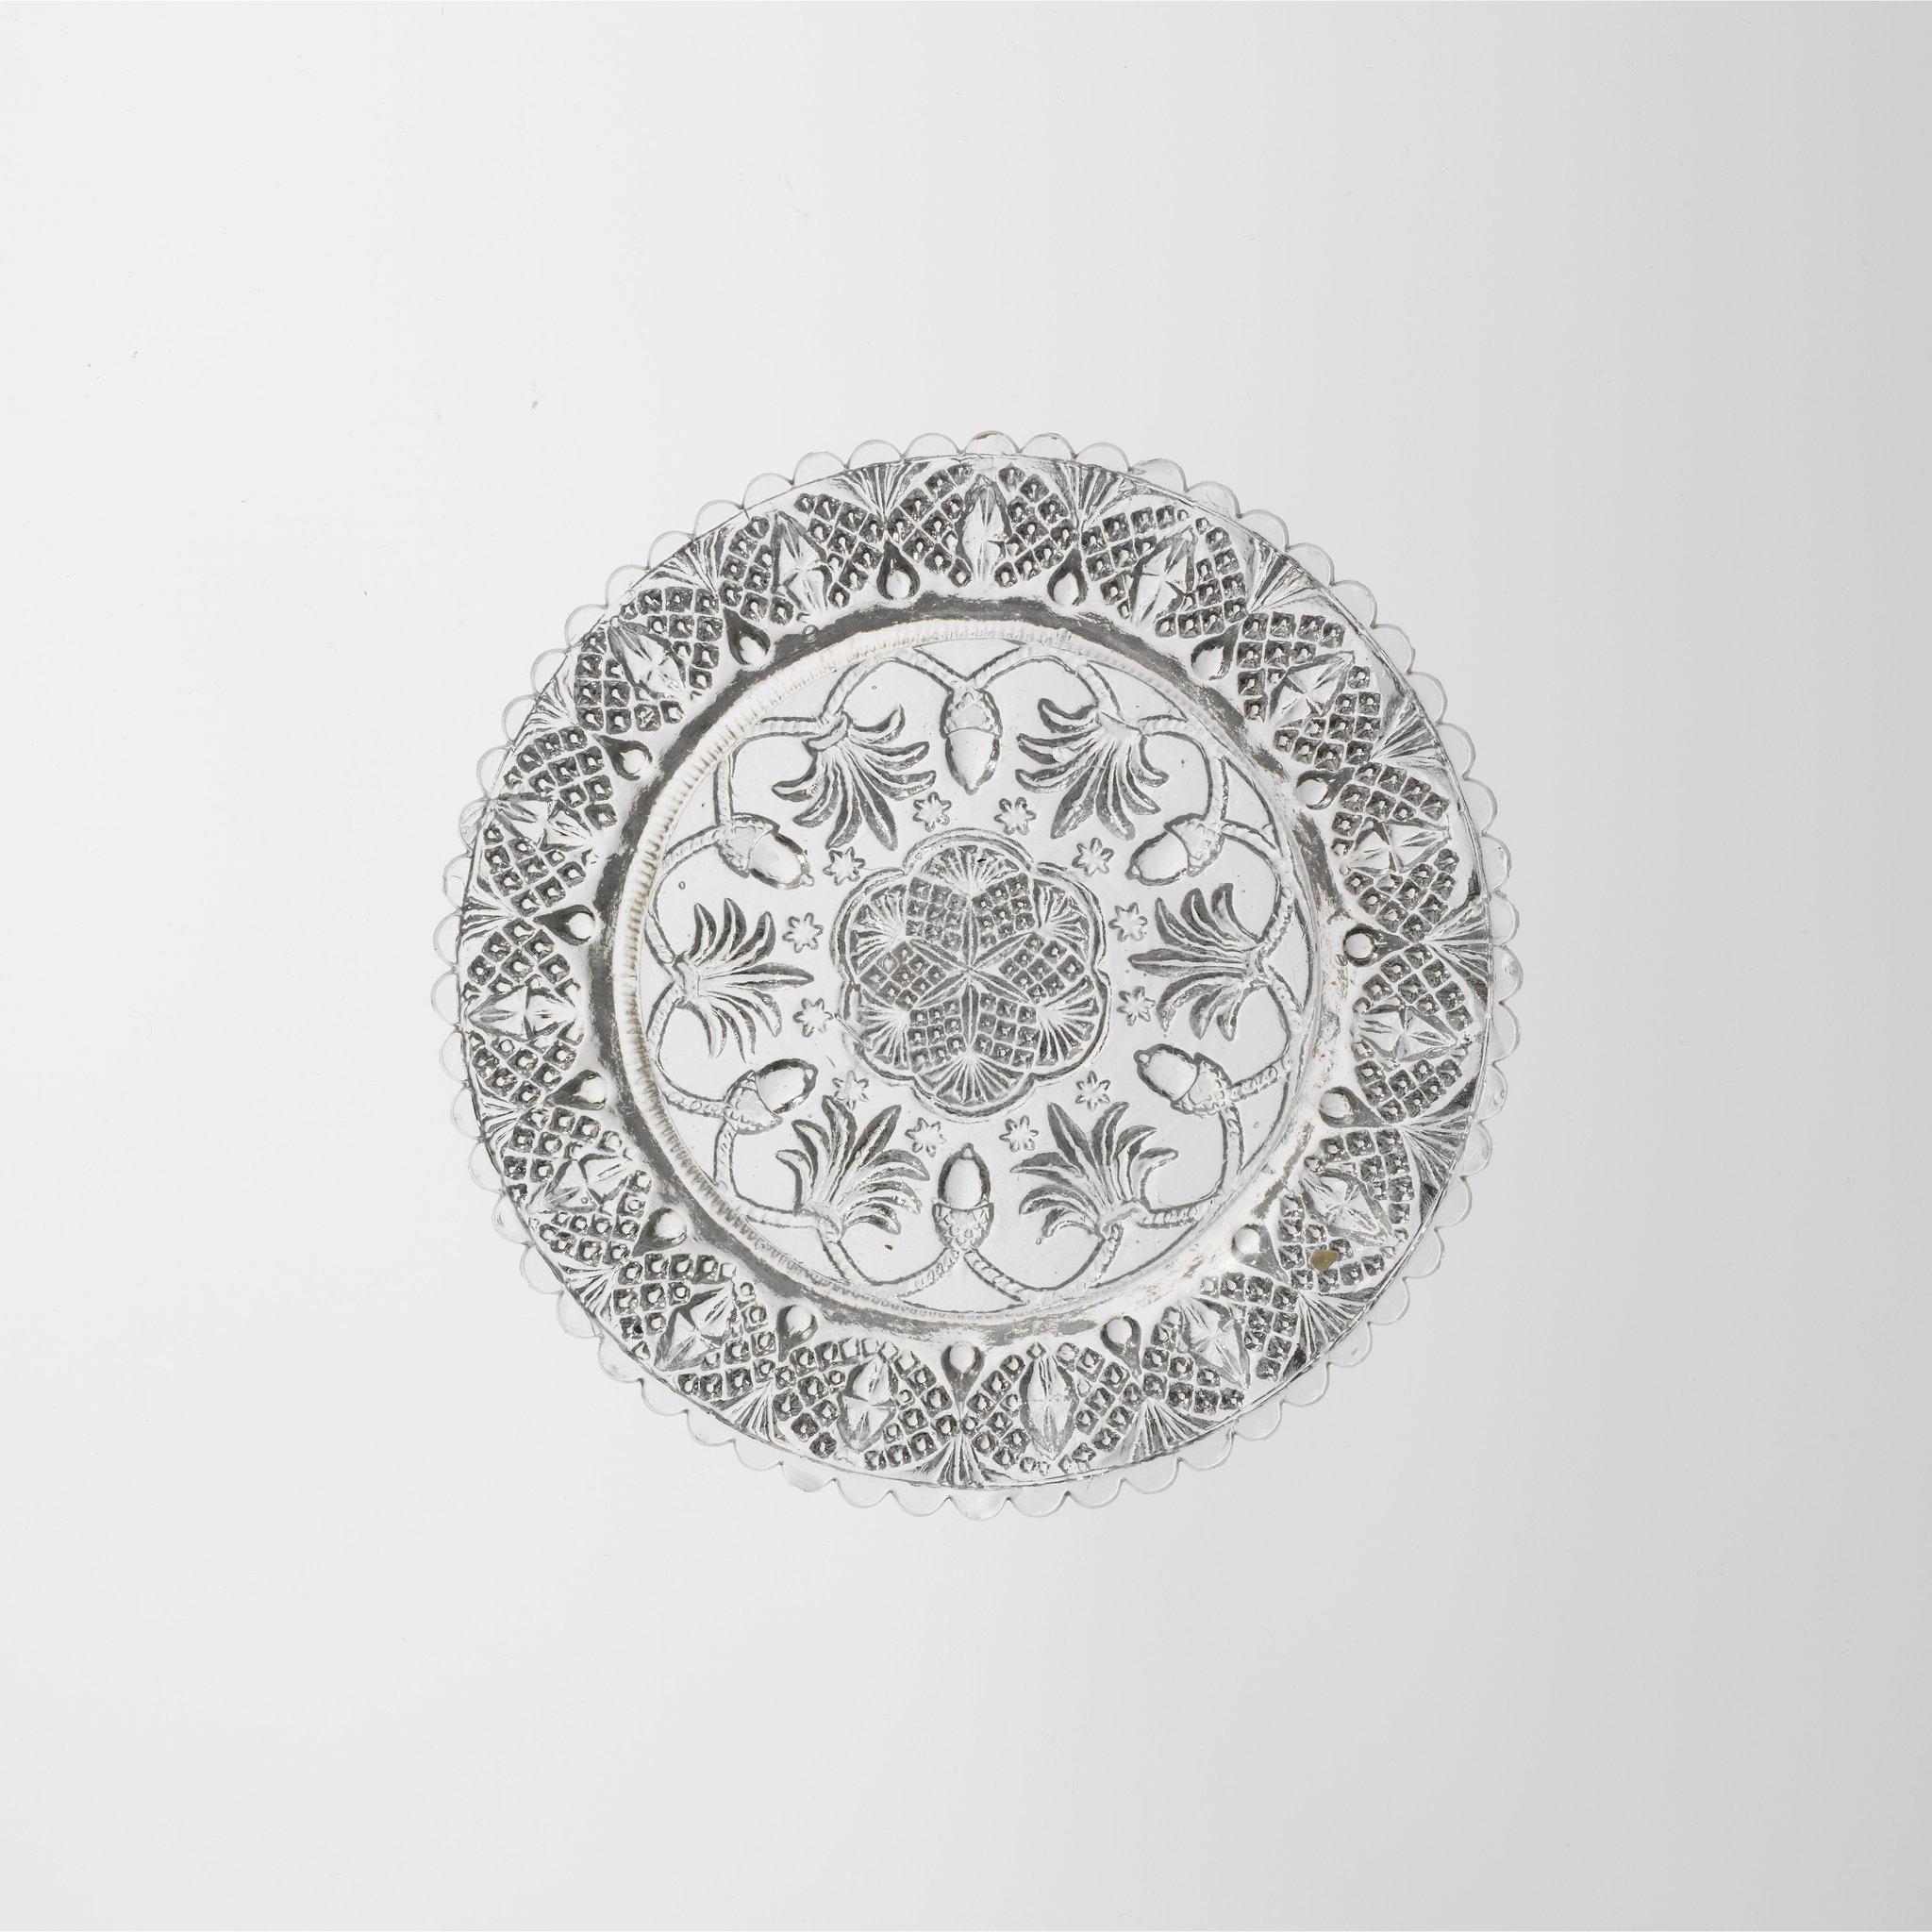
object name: cup plate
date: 1825-1860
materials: glass